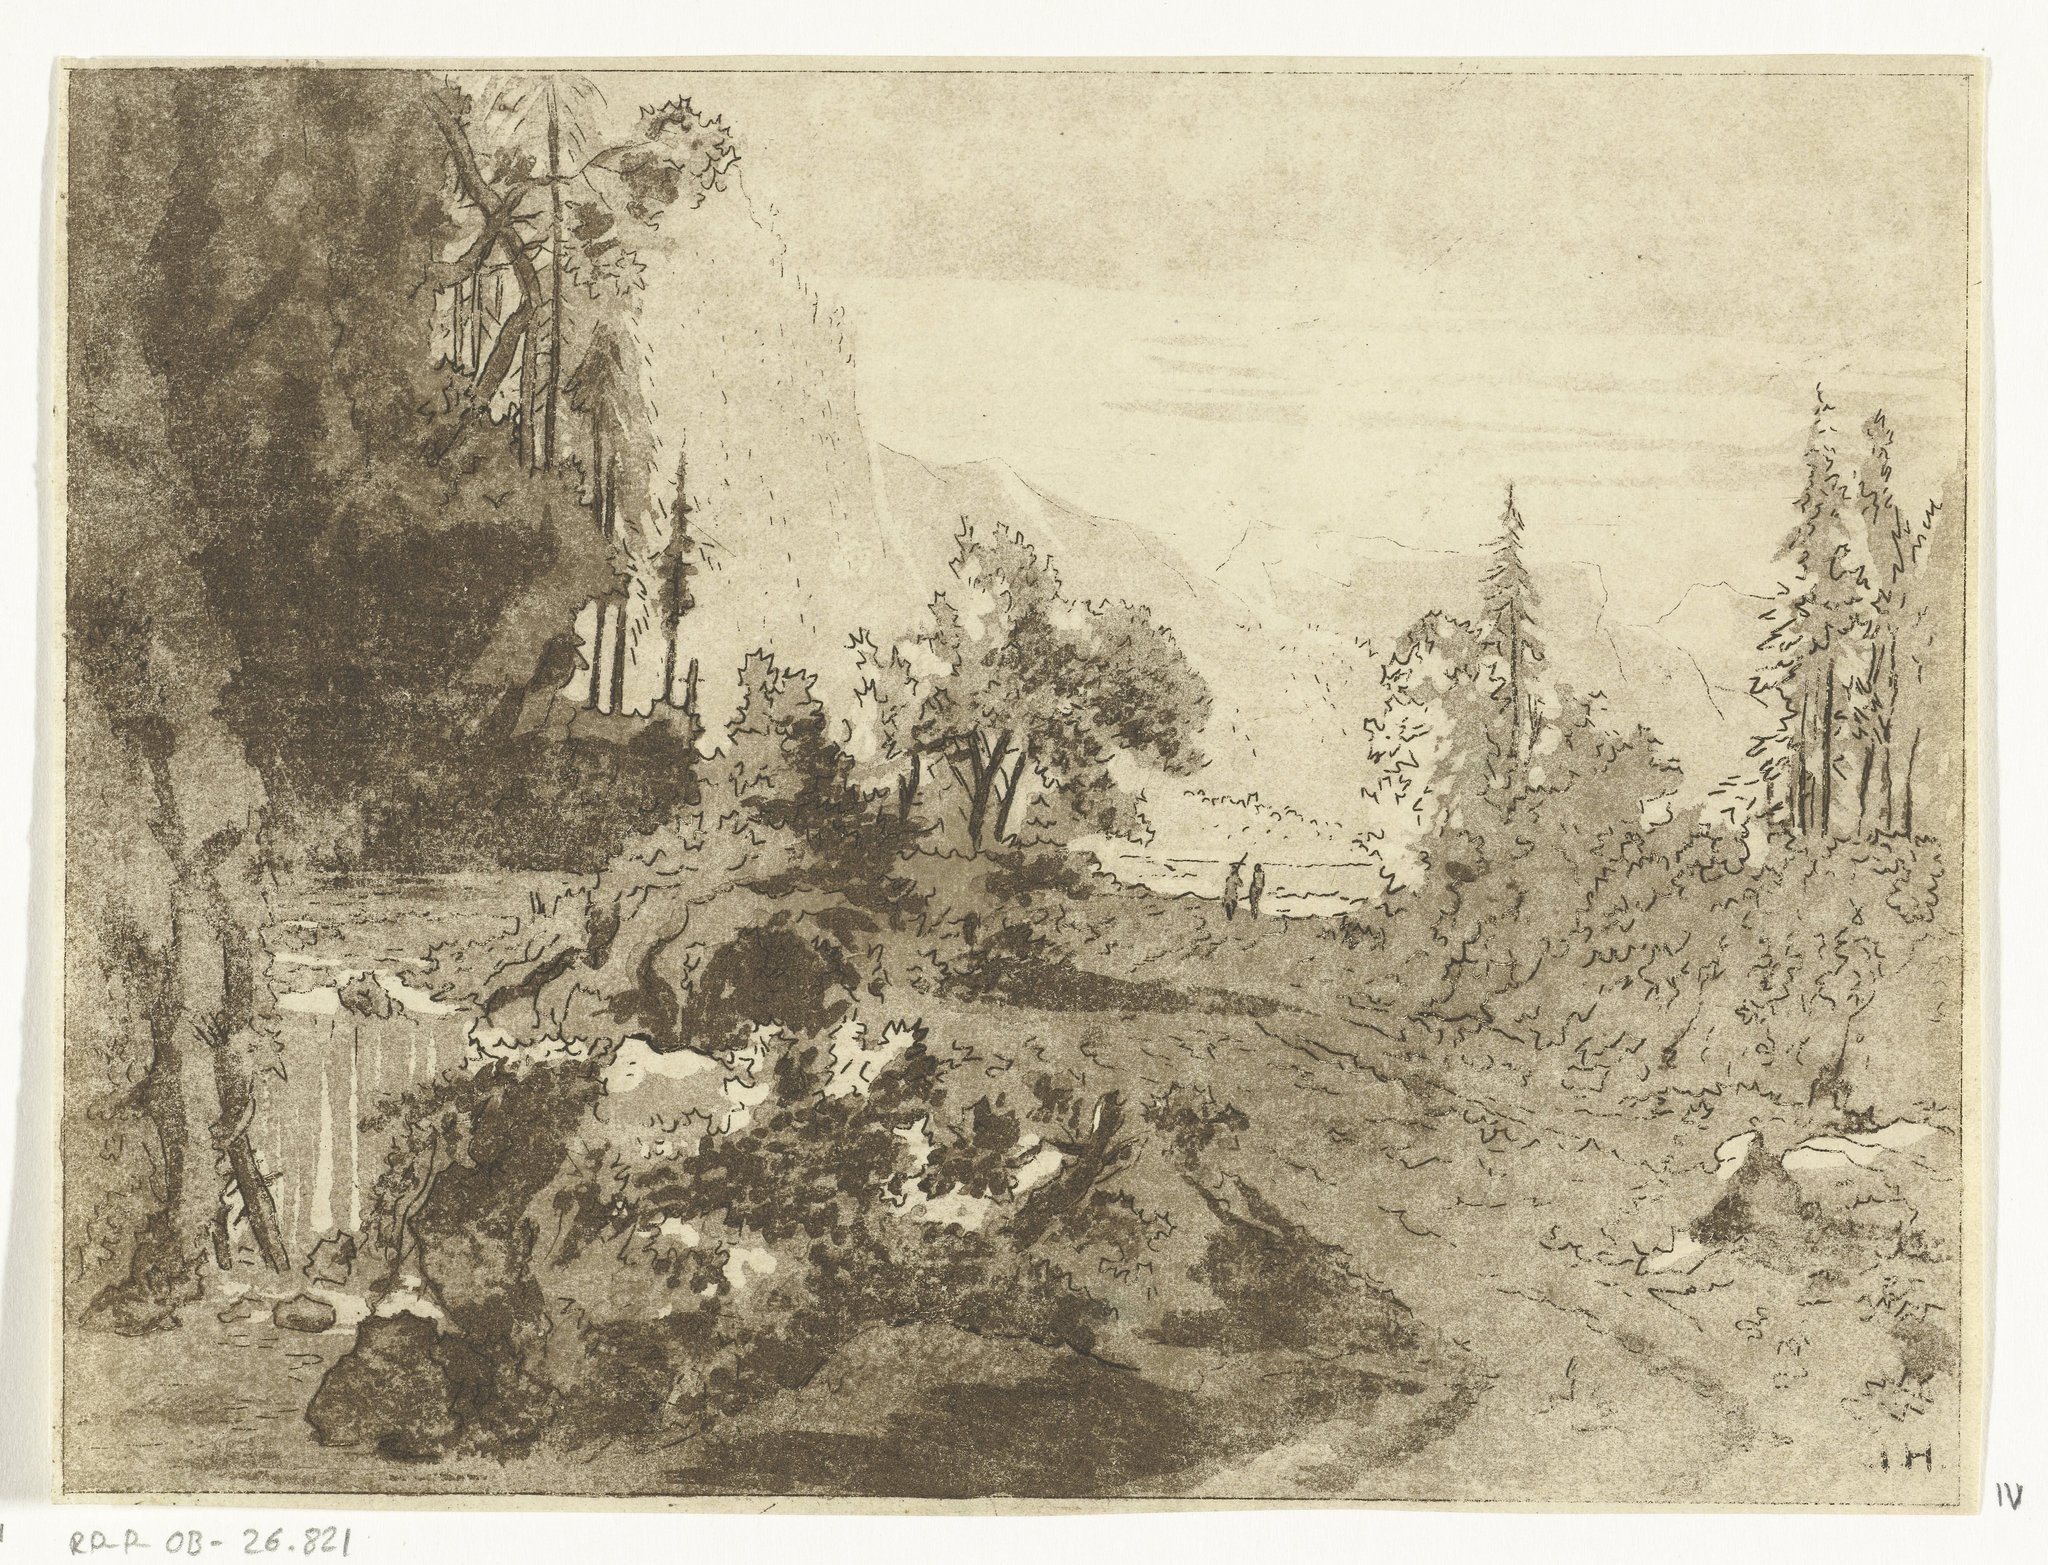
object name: print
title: Bergachtig landschap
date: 1778-1838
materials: paper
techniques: aquatint, etching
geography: netherlands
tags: waterfall, dale, valley (+ landscape with figures, staffage)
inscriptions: collector's mark: Lugt 2228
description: Twee wandelaars lopen op een weg door een valei. Links een waterval.